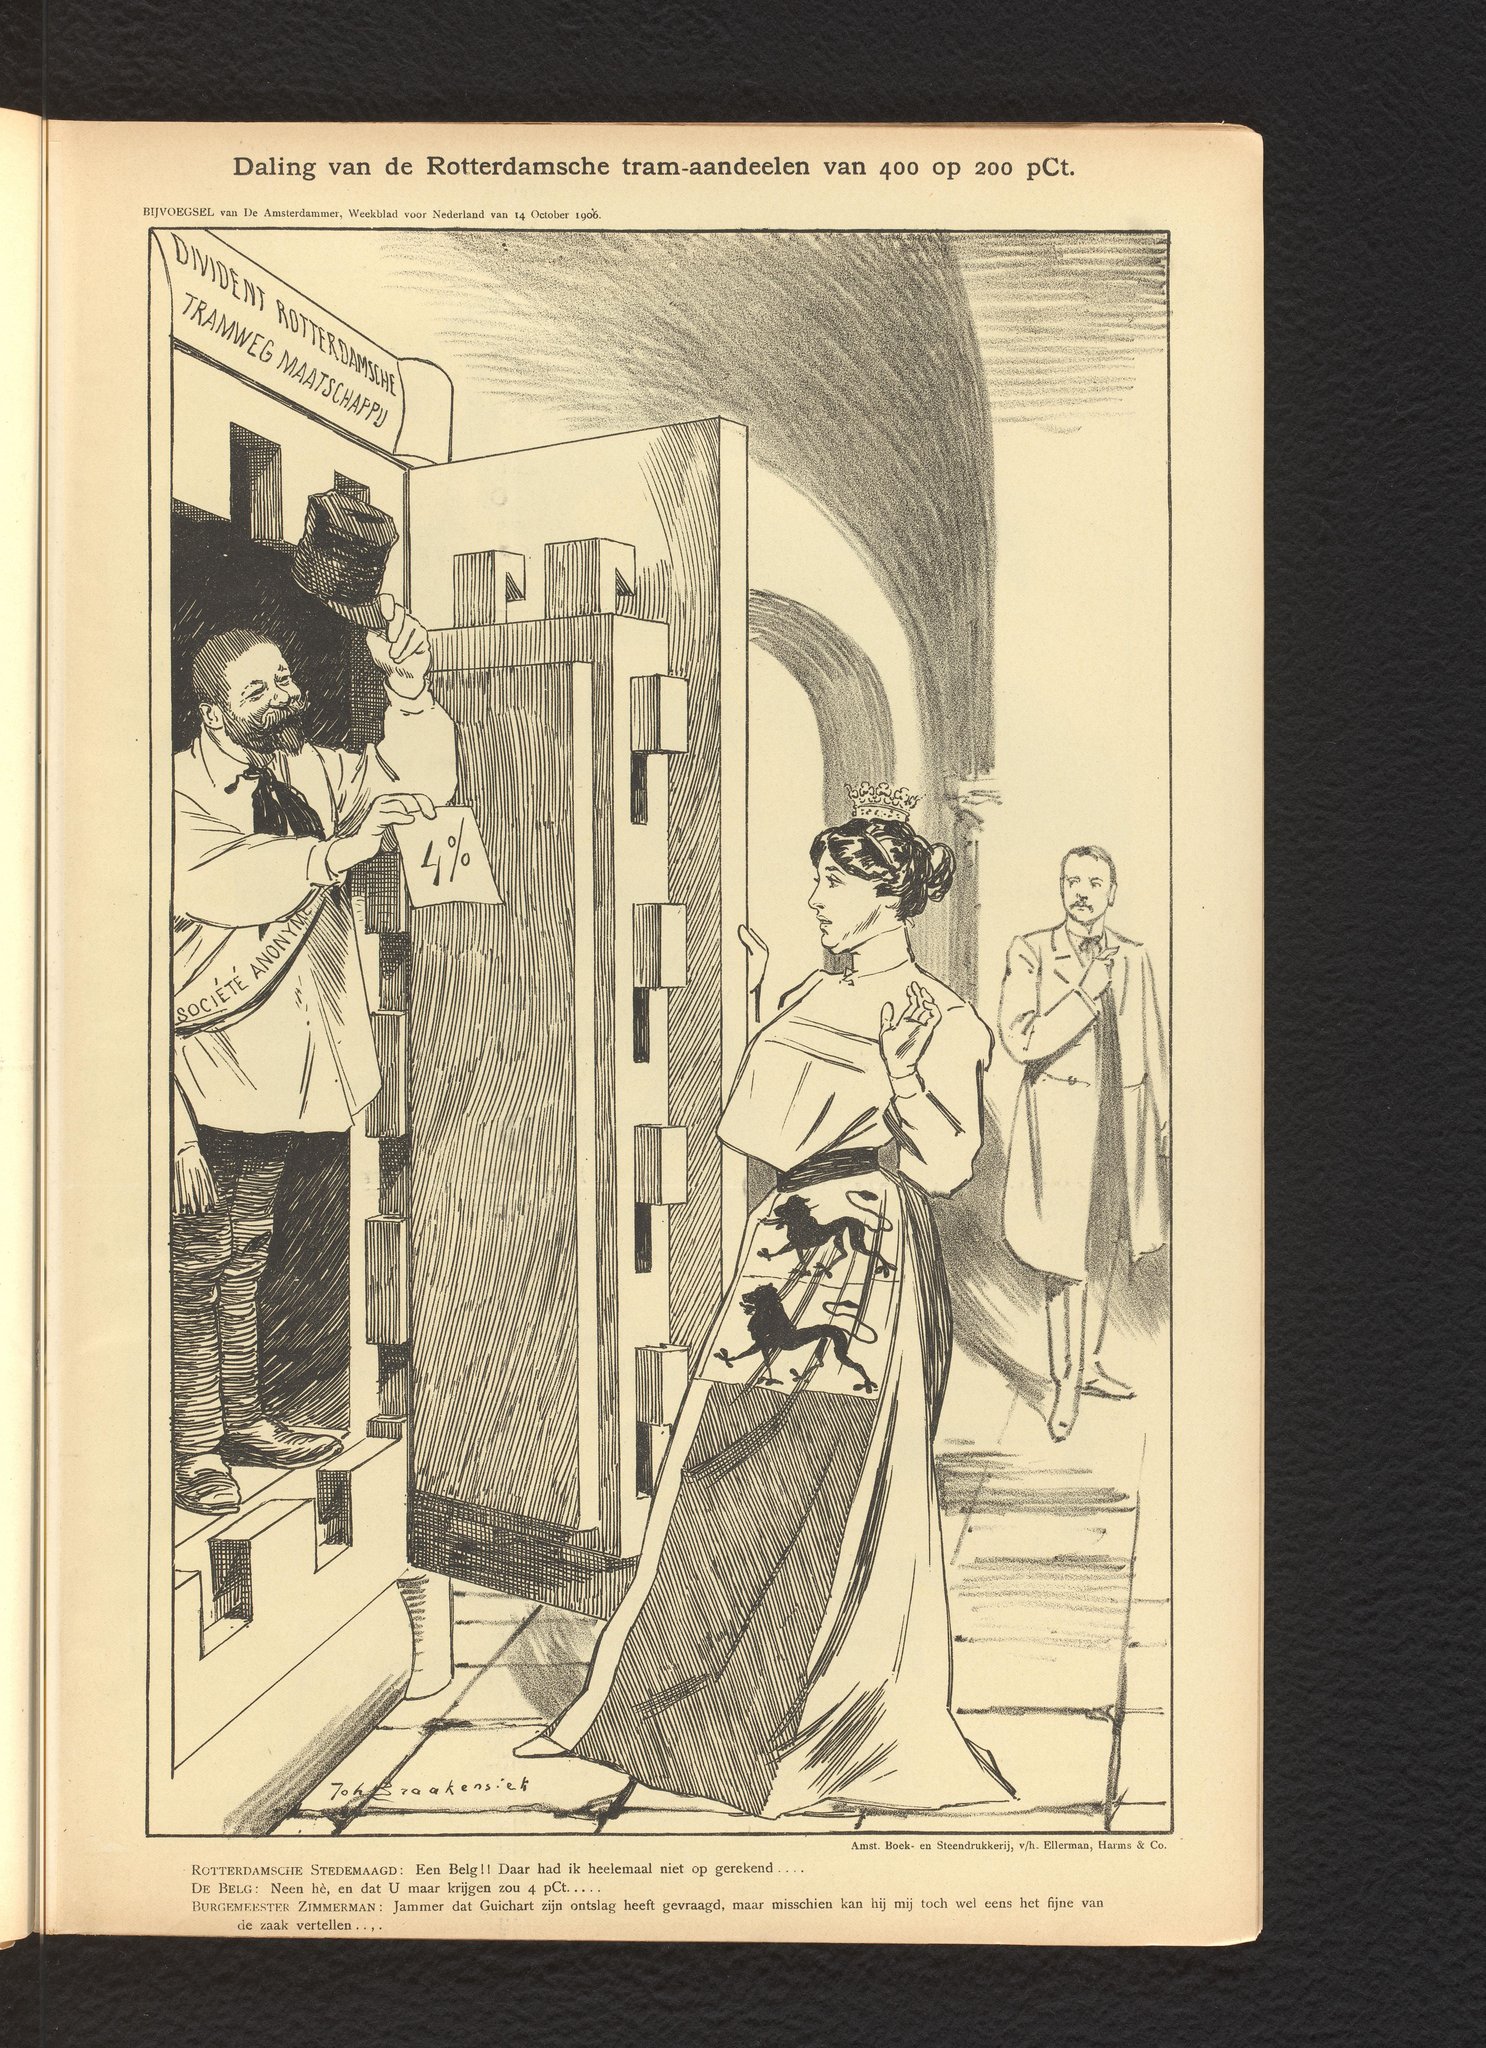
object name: cartoon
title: Daling van de Rotterdamsche tram-aandeelen van 400 op 200 pCt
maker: johan braakensiek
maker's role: draughtsman, print maker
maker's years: 1858-1940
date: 1906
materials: paper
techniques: lithograph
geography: amsterdam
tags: amsterdam, mayor, alfred rudolph zimmerman, tramway, tram, personification of a city, town-patron(ess), political caricatures and satires, rotterdam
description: De Rotterdamse Maagd schrikt als een Belg bij de deur een daling van de dividend van de Rotterdamsche Tramweg Maatschappij aankondigt. Op de achtergrond de Rotterdamse burgemeester Alfred Zimmerman.